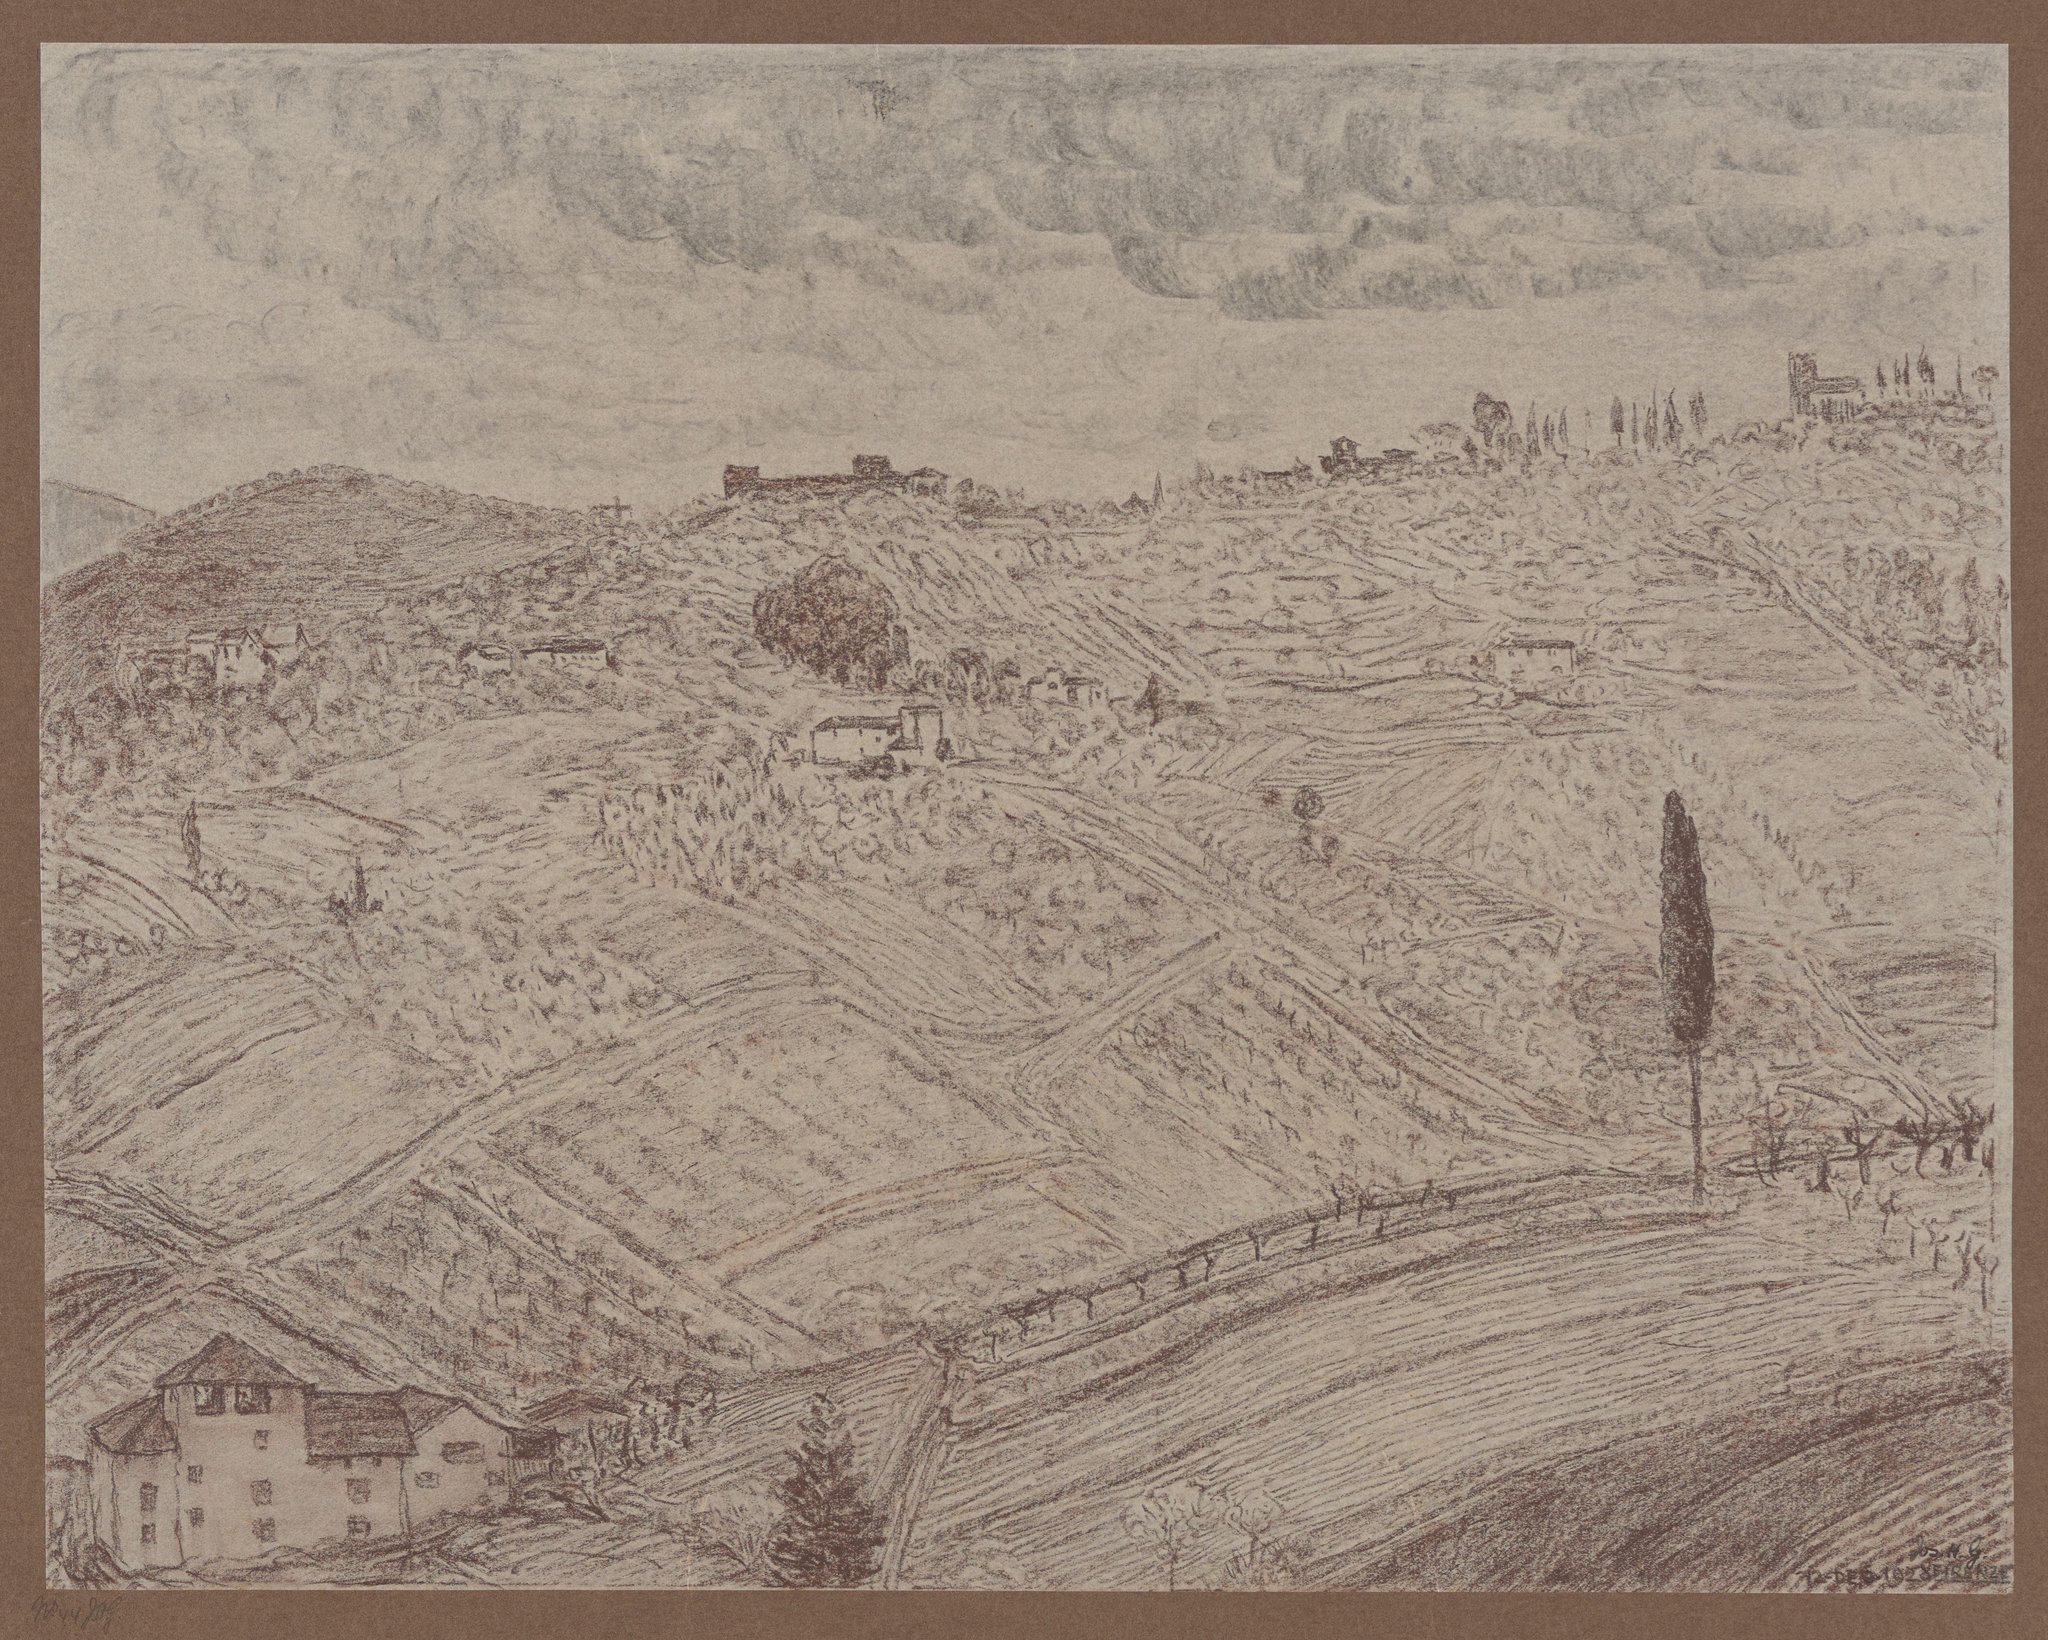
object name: drawing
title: Landschap bij Florence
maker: joseph henry gosschalk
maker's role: draughtsman, print maker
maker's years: 1875-1952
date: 1928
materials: chalk, charcoal, paper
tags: low hill country